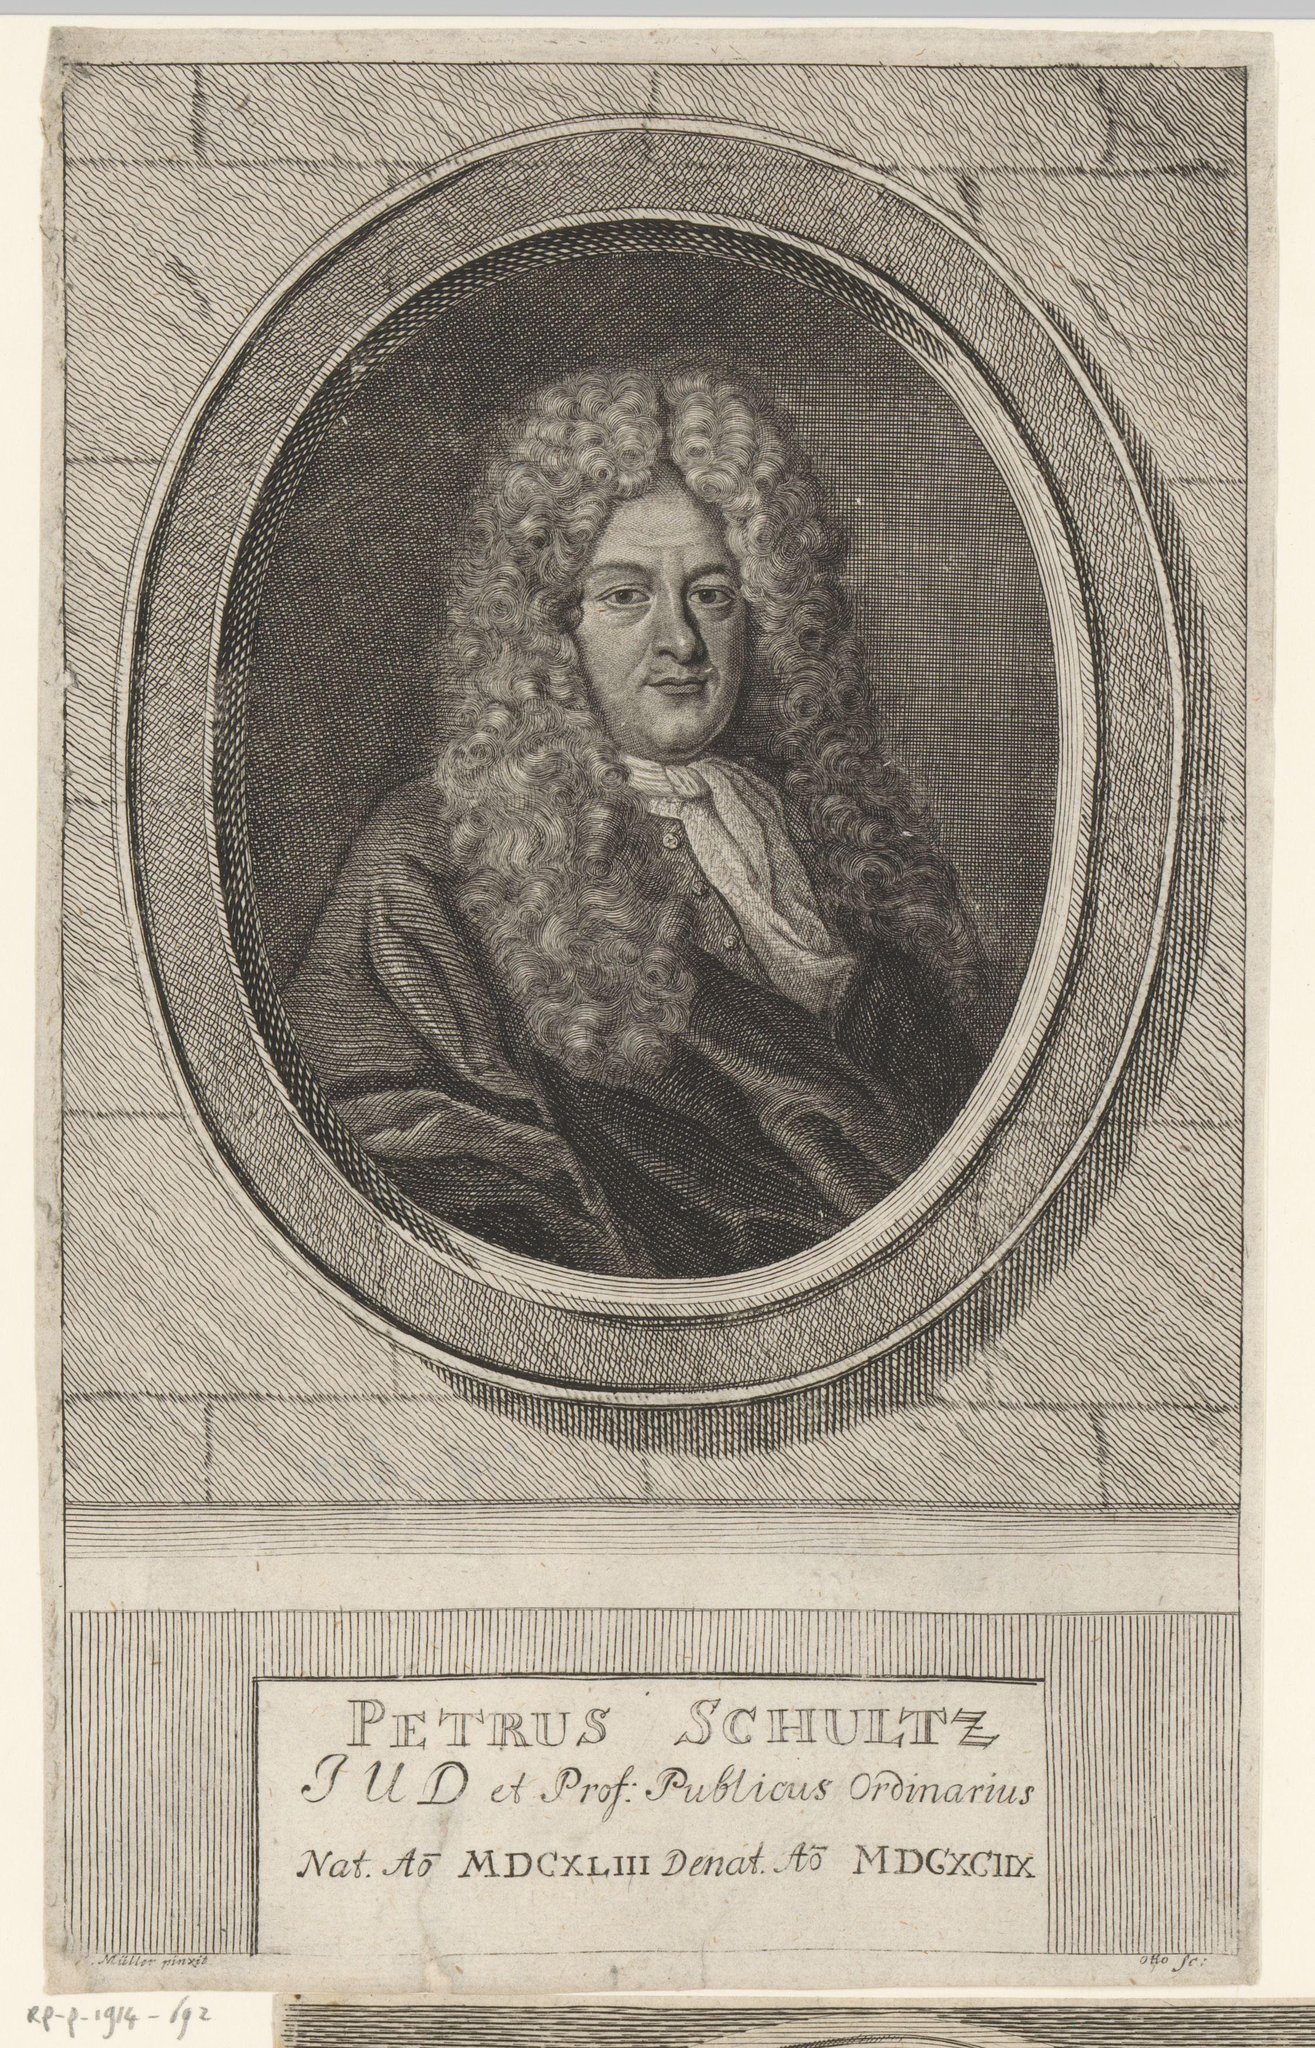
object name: print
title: Portret van Peter Schultz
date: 1658-1749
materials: paper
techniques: engraving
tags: historical persons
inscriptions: collector's mark: Lugt 2228